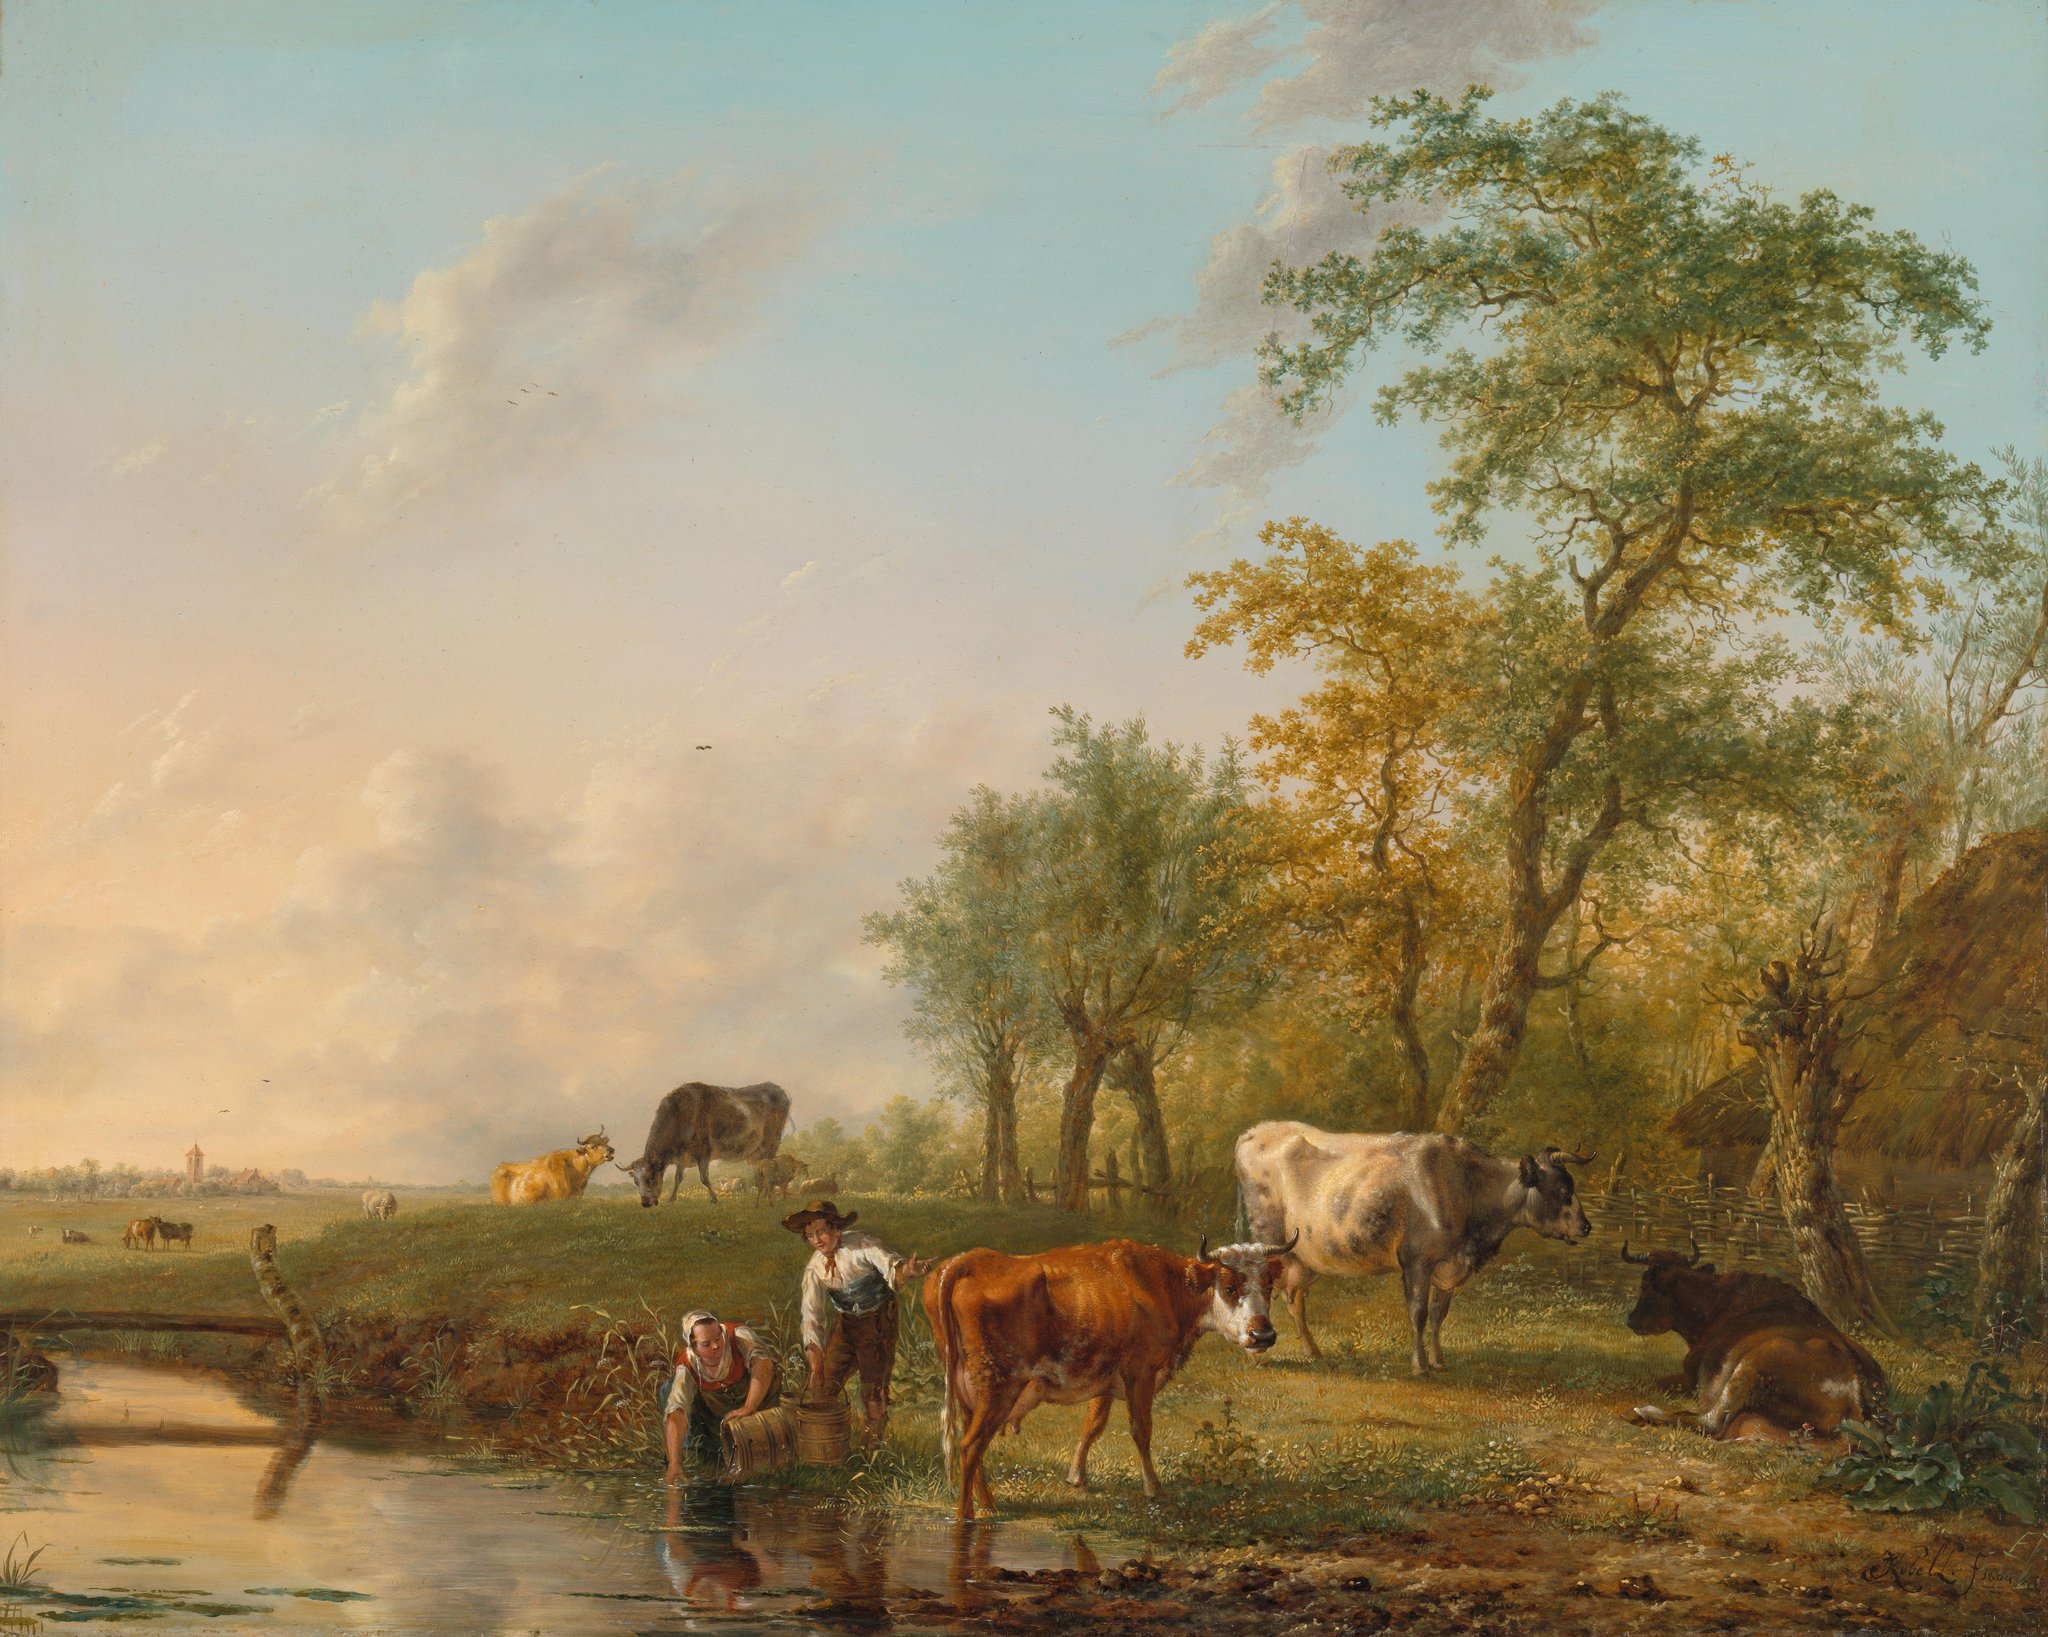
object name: painting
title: Landscape with Cattle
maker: jan kobell (ii)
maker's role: draughtsman, painter, print maker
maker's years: 1778-1814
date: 1804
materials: oil, panel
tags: cattle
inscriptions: signature and date: ‘J. Kobell f 1804’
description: Landschap met vee. Op de voorgrond vullen een man en vrouw emmers in een sloot. Rechts een boerenschuur met een rieten dak onder bomen. Hiervoor drie koeien.